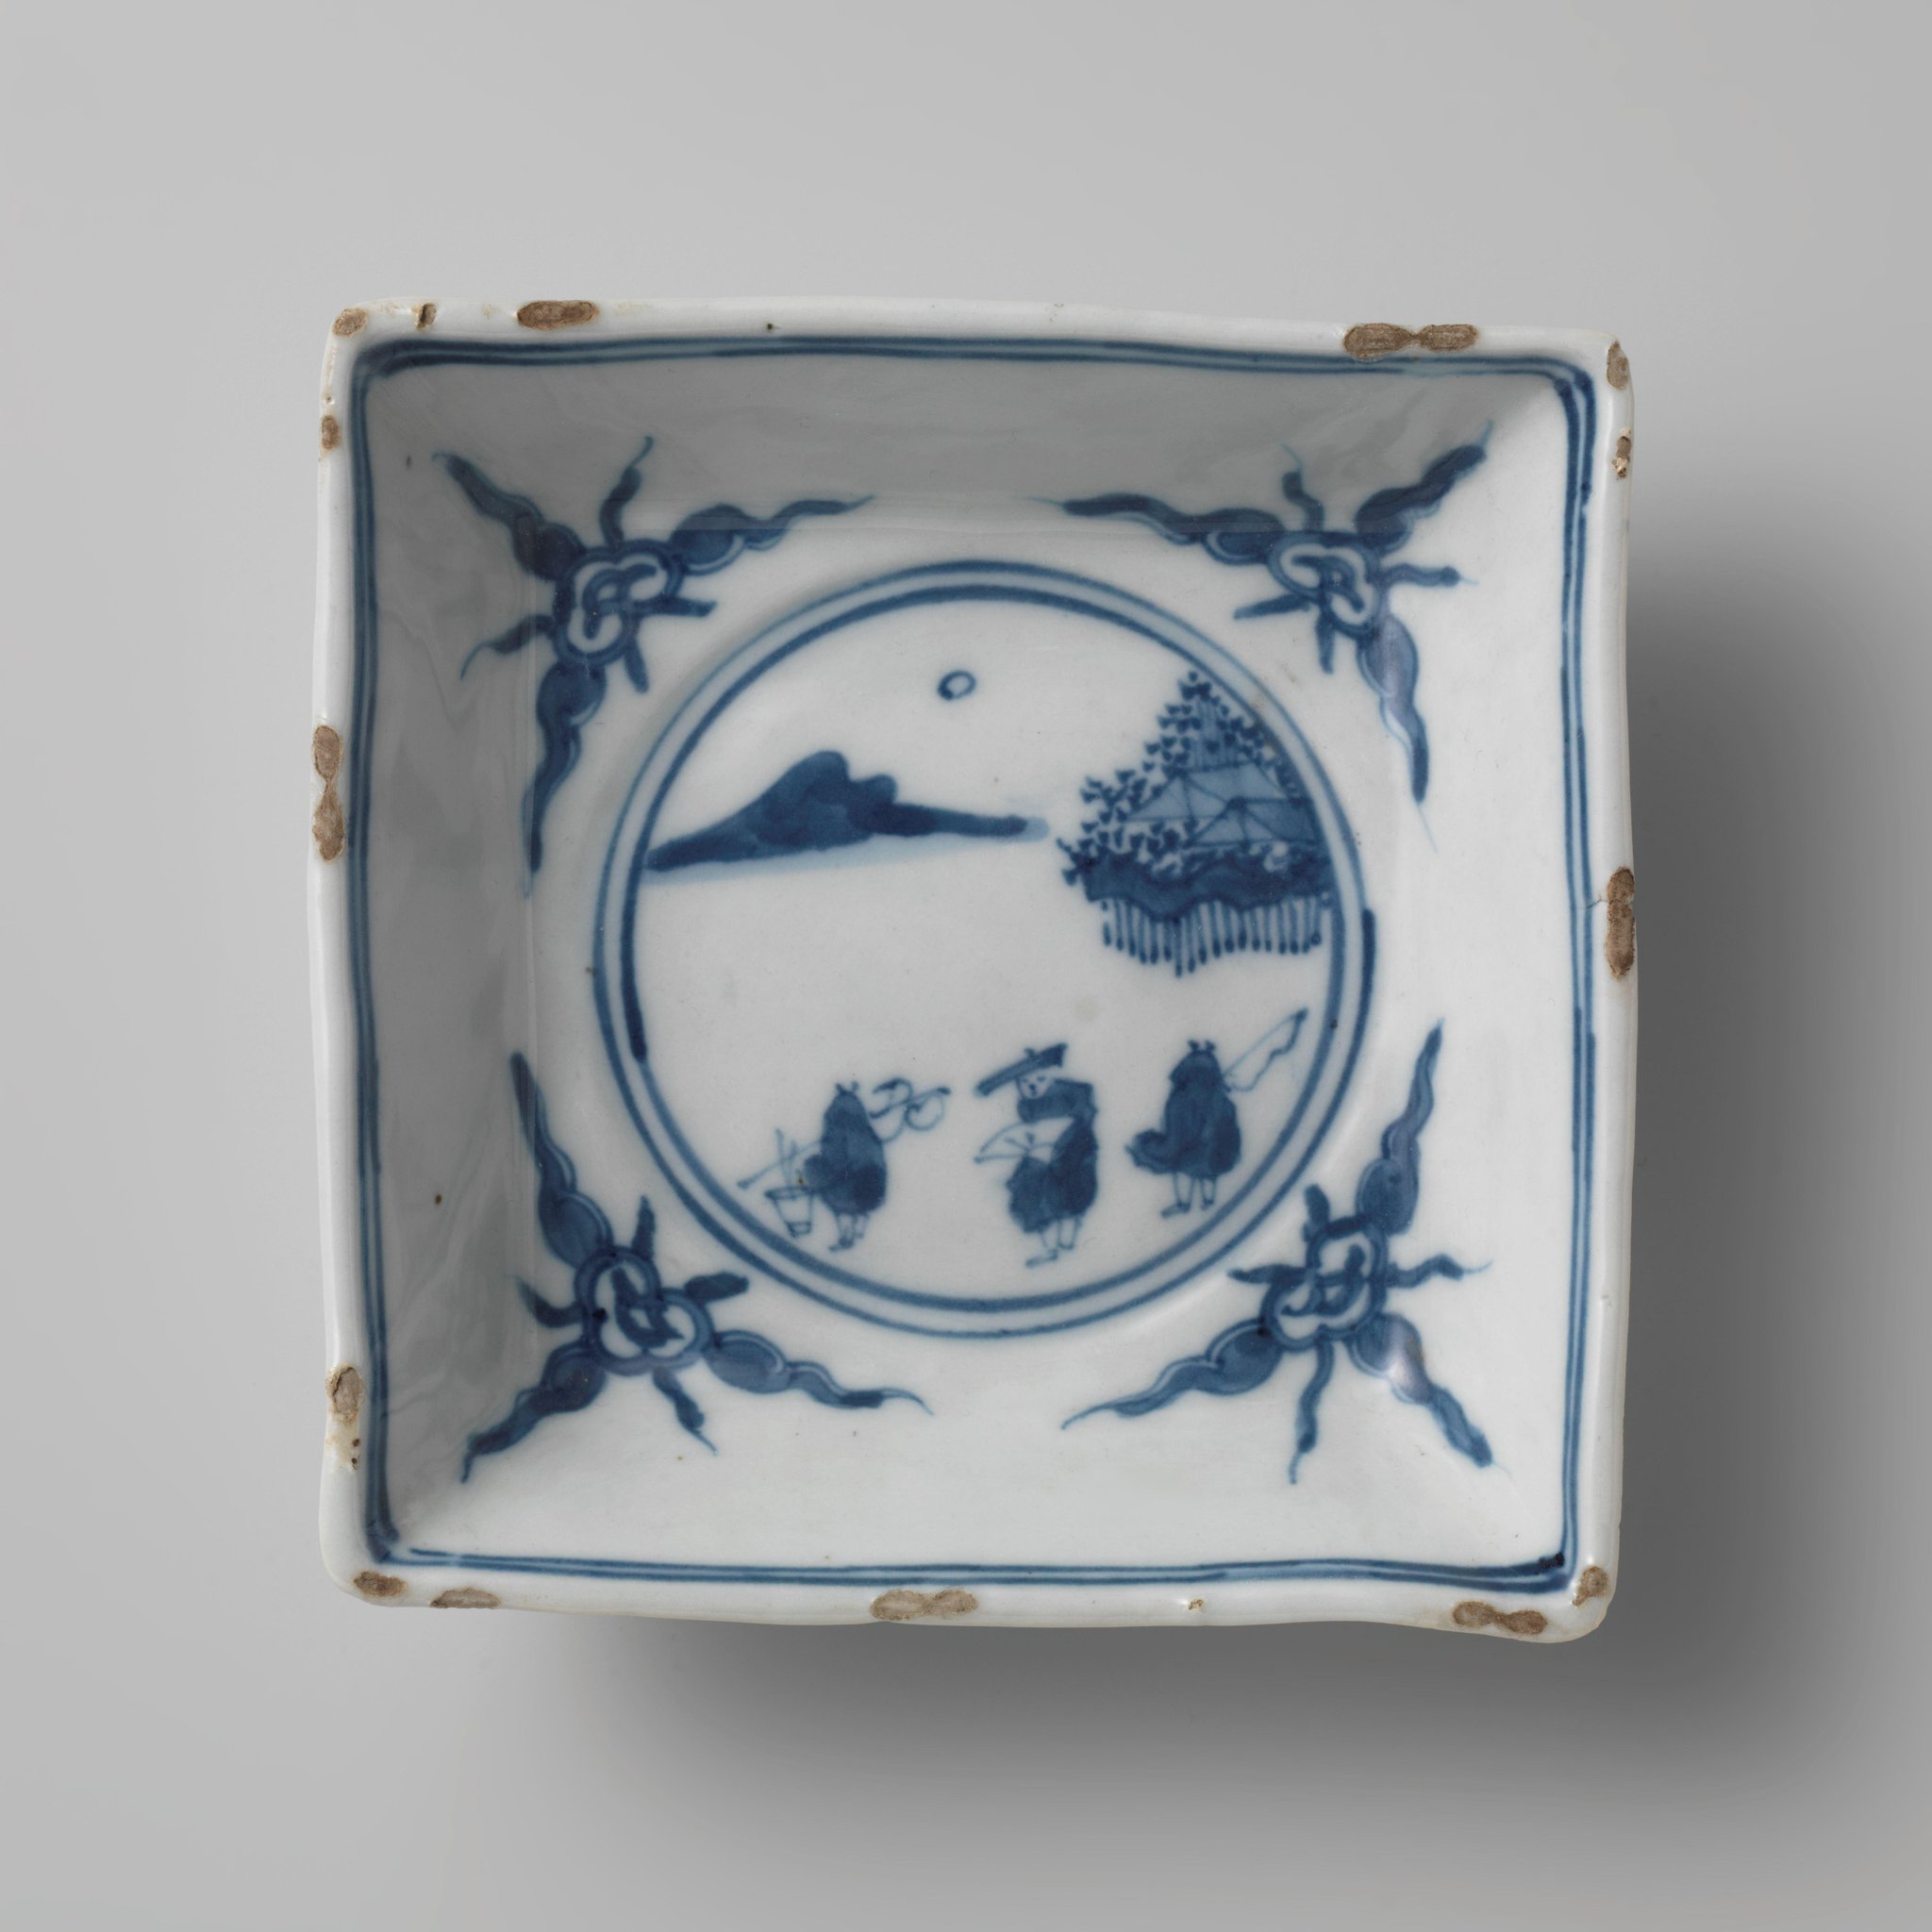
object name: bowl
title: Square bowl with three figures in a landscape in a medallion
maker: Anonymous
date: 1700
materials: cobalt, glaze, paint, porcelain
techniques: firing, forming, vitrification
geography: arita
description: Vierkante kom van porselein, beschilderd in onderglazuur blauw. Op de bodem een dubbel medaillon met daarin een landschap met bergen, huizen en drie personen: één waterdrager, één met een waaier en één met een soort hengel. In elke hoek een wolk met ruyi-motief. Glazuur op de rand en de hoeken afgesprongen. Arita, blauw-wit.